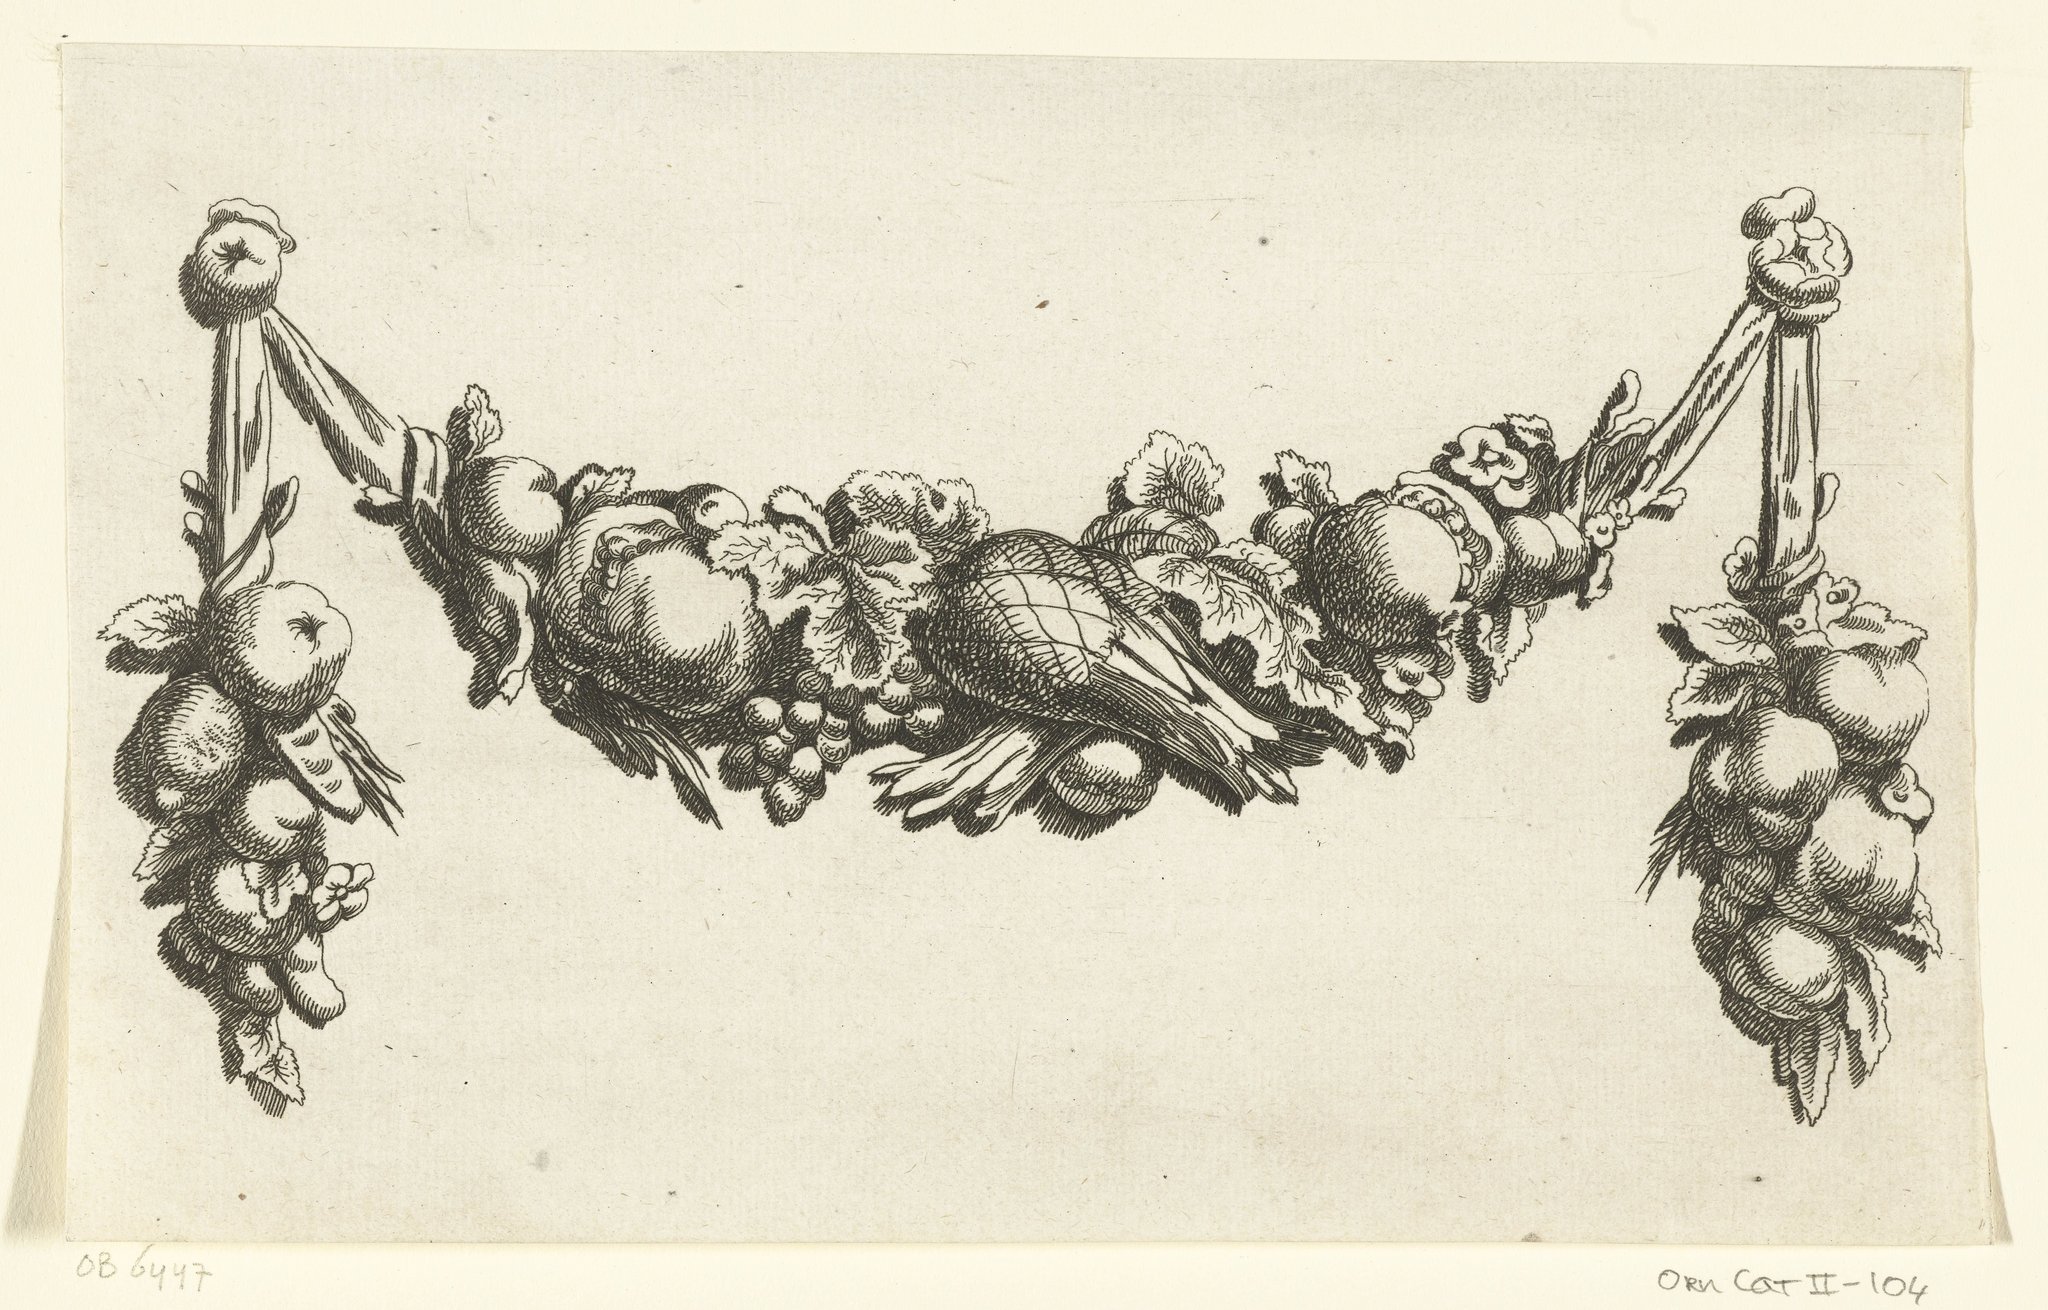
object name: print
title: Festoen met een ananas in het midden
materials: paper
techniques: etching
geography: amsterdam